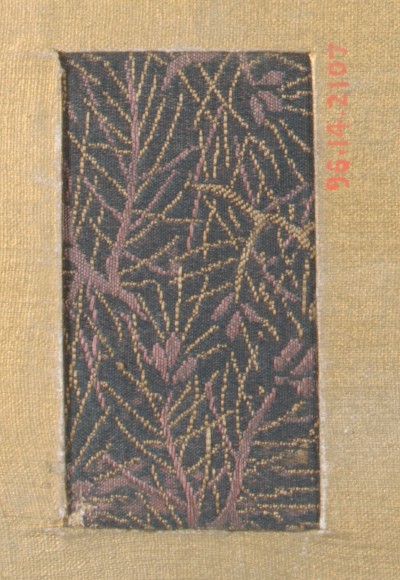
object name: piece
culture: japanese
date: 1701-1900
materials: silk